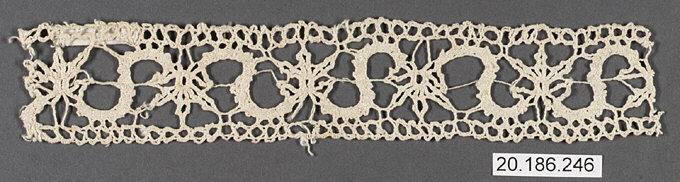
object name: insertion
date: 1601-1700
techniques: lace